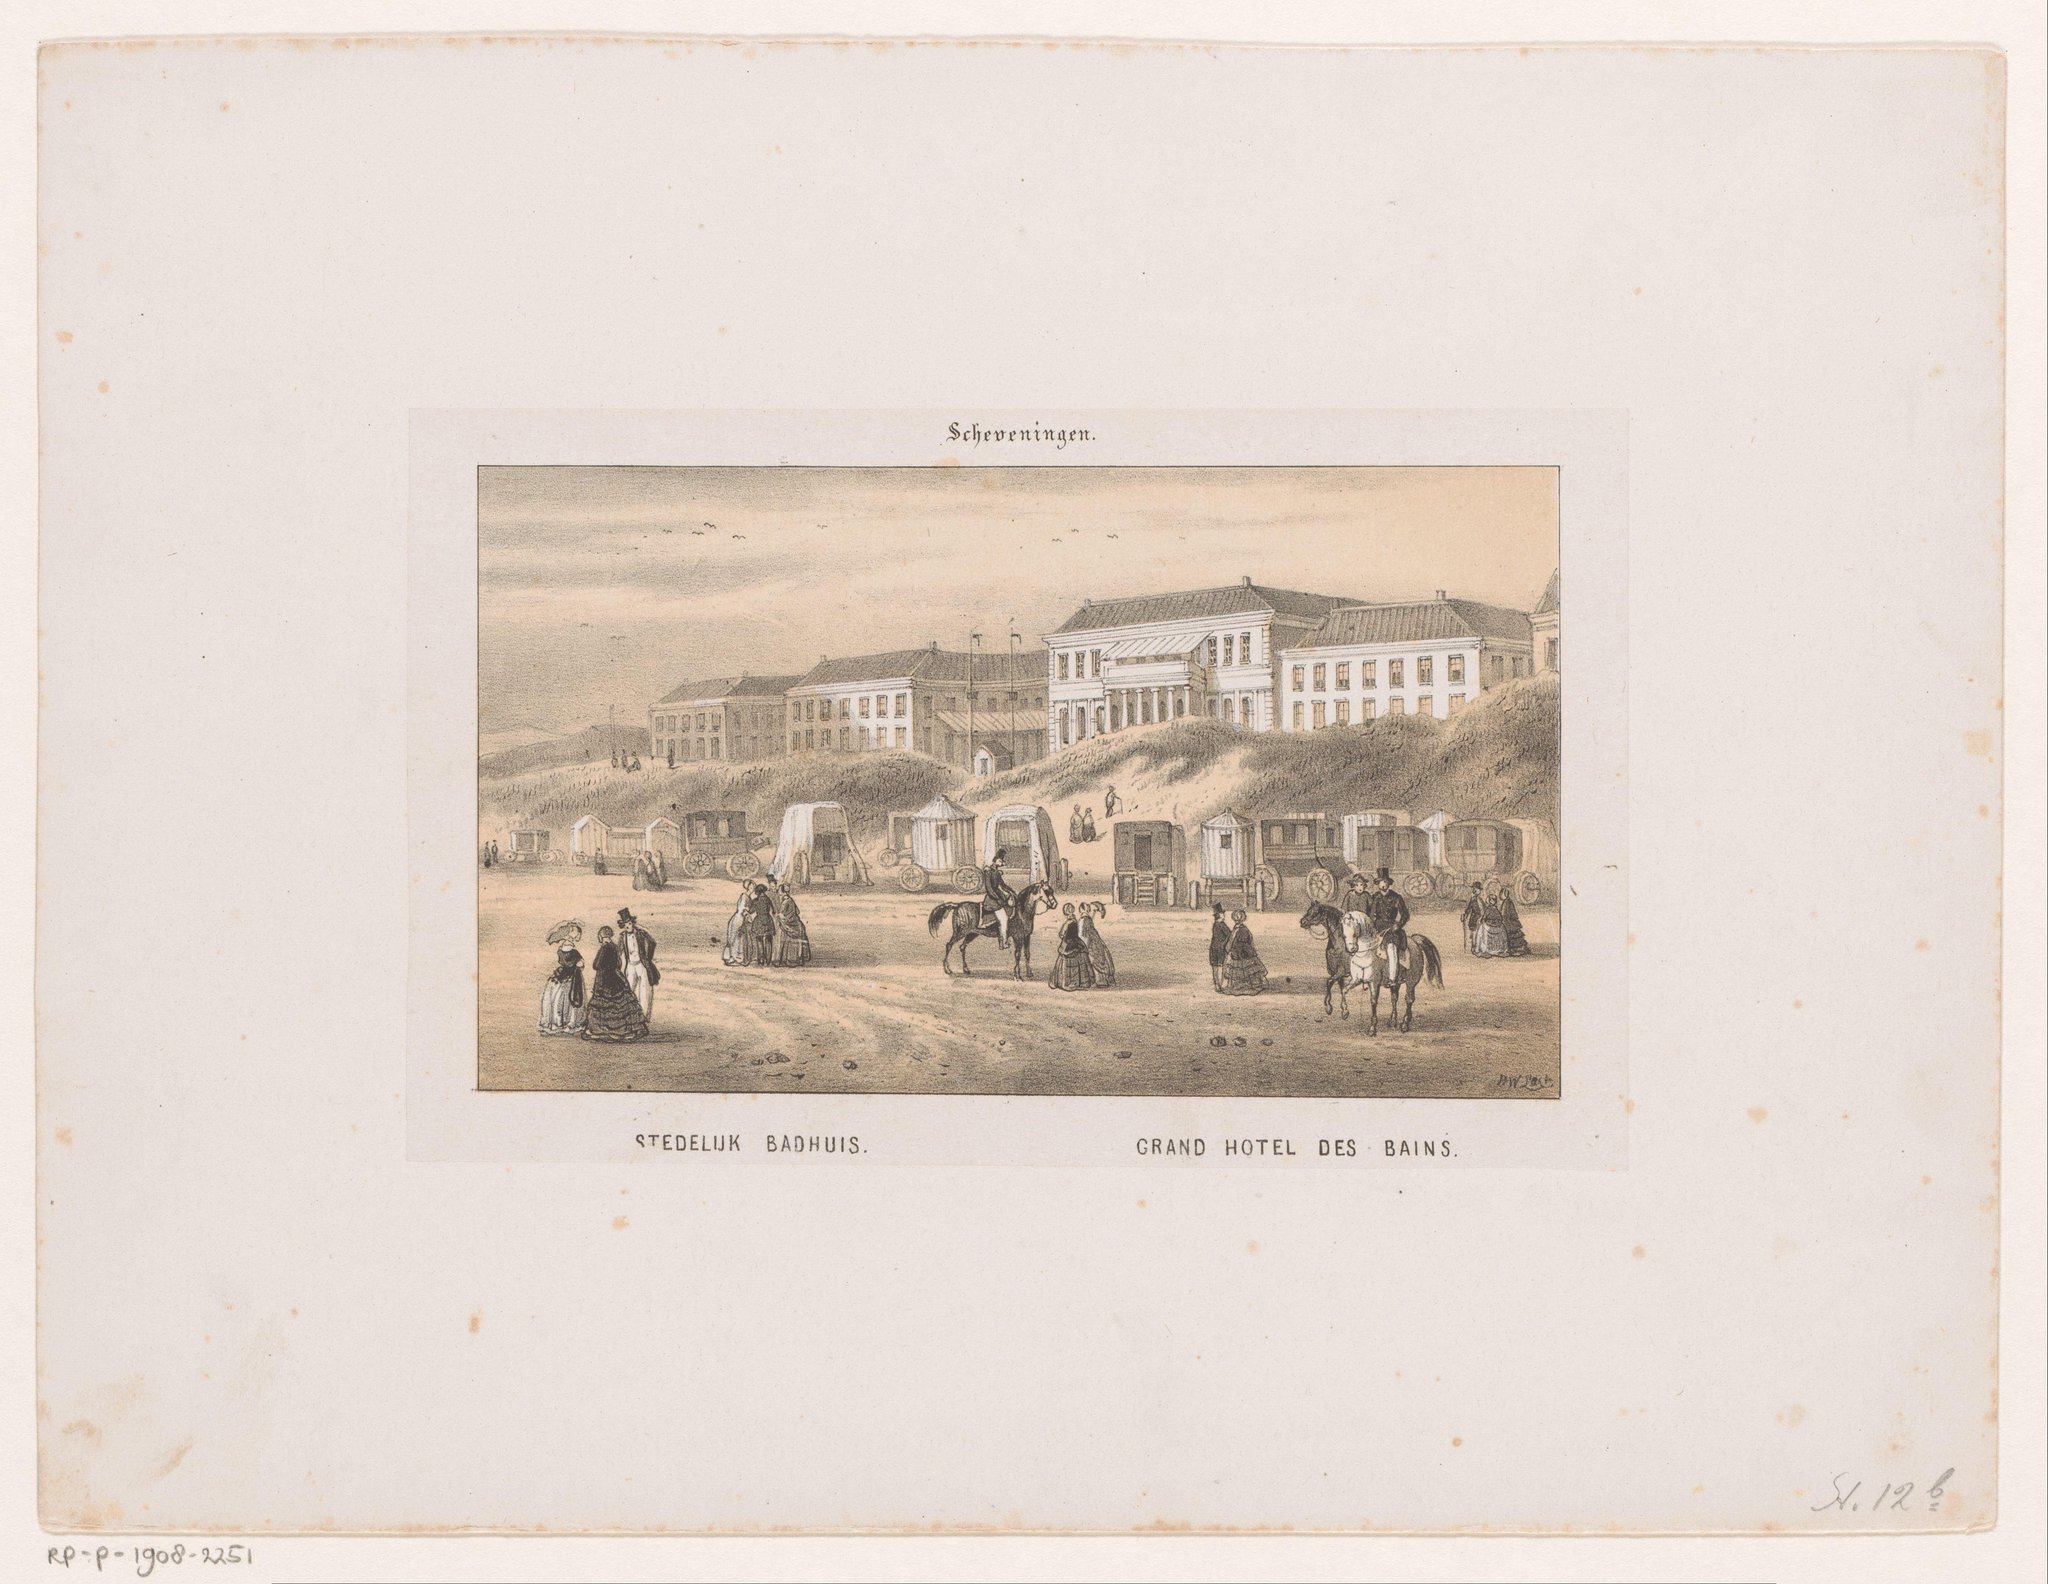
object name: print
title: Herinnering aan Scheveningen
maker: hendrik wilhelmus last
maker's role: print maker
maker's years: 1817-1873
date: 1827-1873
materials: paper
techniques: tone lithography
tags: beach (as place of recreation), public baths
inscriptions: collector's mark: Lugt 2228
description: Tegen de duinen, voor het badhuis, staan rijtuigen en kleine strandhuizen op wielen. Op het strand wandelen figuren en ruiters.